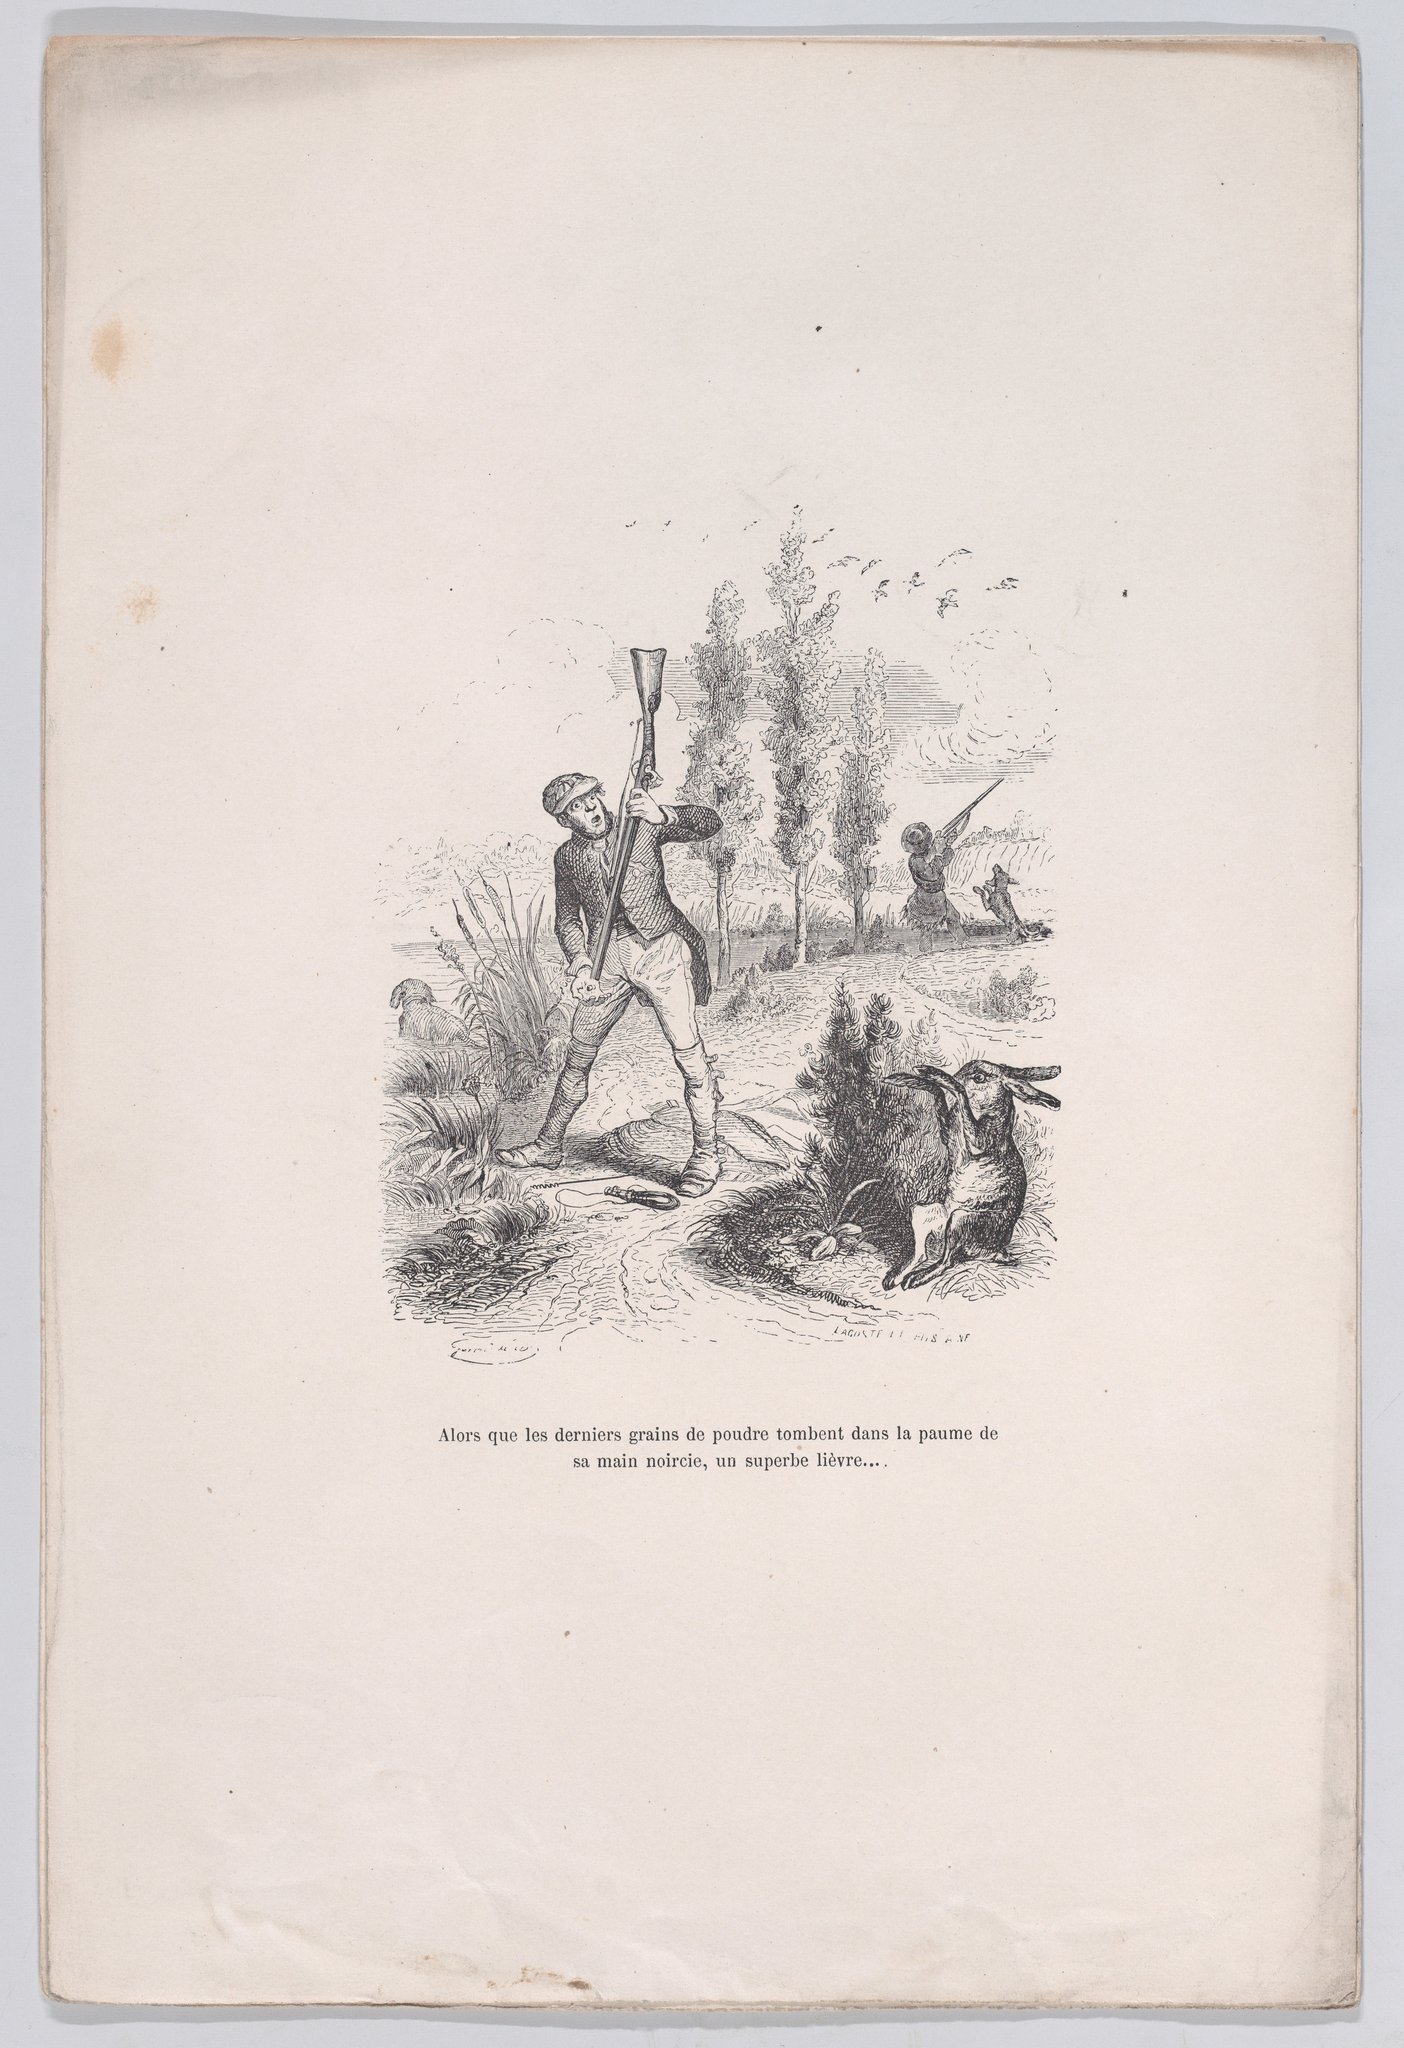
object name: print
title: As the last grains of powder fall into the palm of his blackened hand, a superb hare..., from "Little Miseries of Human Life"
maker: j. j. grandville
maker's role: illustrator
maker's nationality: french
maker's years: 1803-1847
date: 1843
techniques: engraving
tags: men,hunting,rabbits